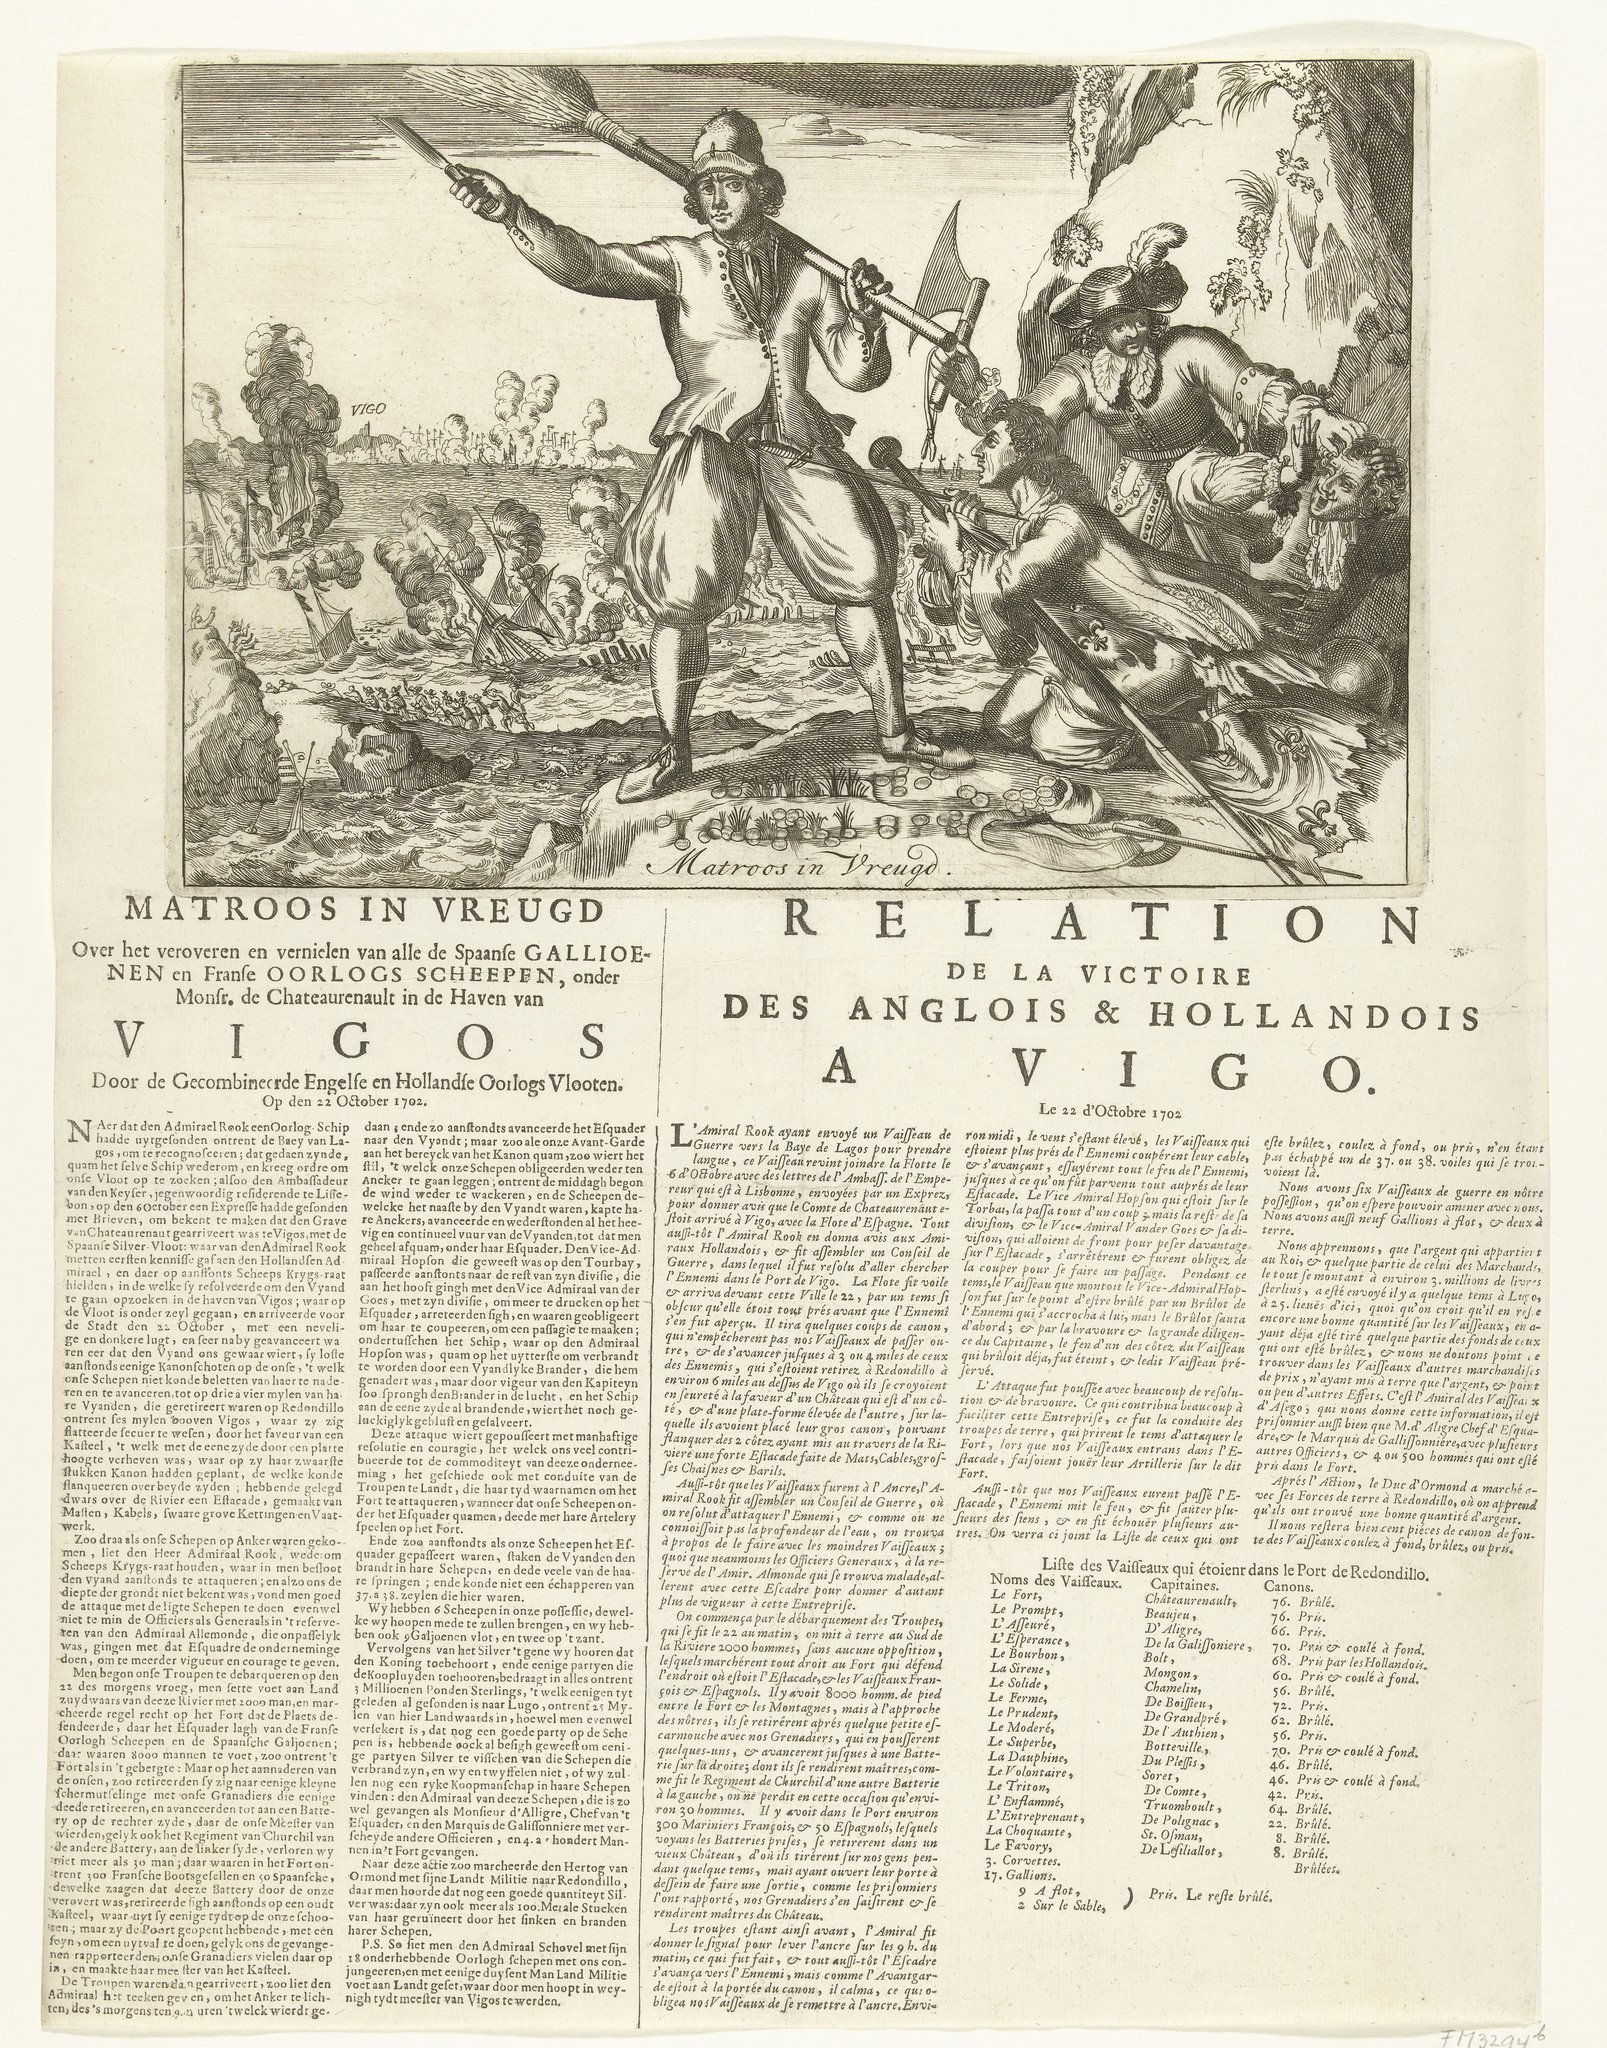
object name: cartoon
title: Matroos in Vreugd Over het veroveren en vernielen van alle de Spaanse Gallioenen en Franse Oorlogs Scheepen, onder Monsr. de Chateaurenault in de Haven van Vigos Door de Gecombineerde Engelse en Hollandse Oorlogs Vlooten. Op den 22 October 1702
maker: Anonymous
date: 1692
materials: paper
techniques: engraving, etching, letterpress printing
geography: northern netherlands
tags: political caricatures and satires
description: Spotprent op de overwinning van de Engelsen en Hollanders op de Fransen en Spanjaarden in de zeeslag bij Vigo, 23 oktober 1702. De Hollandse matroos met bezem over de schouder staat op rots bij zee waarop schepen aan het vergaan zijn. Aan zijn voeten smeekt een Fransman om genade. Rechts bedreigt een Engelsman een Spanjaard met een hakbijl. Op het blad onder de plaat een tekst met 2 kolommen in het Nederlands en 3 kolommen in het Frans.